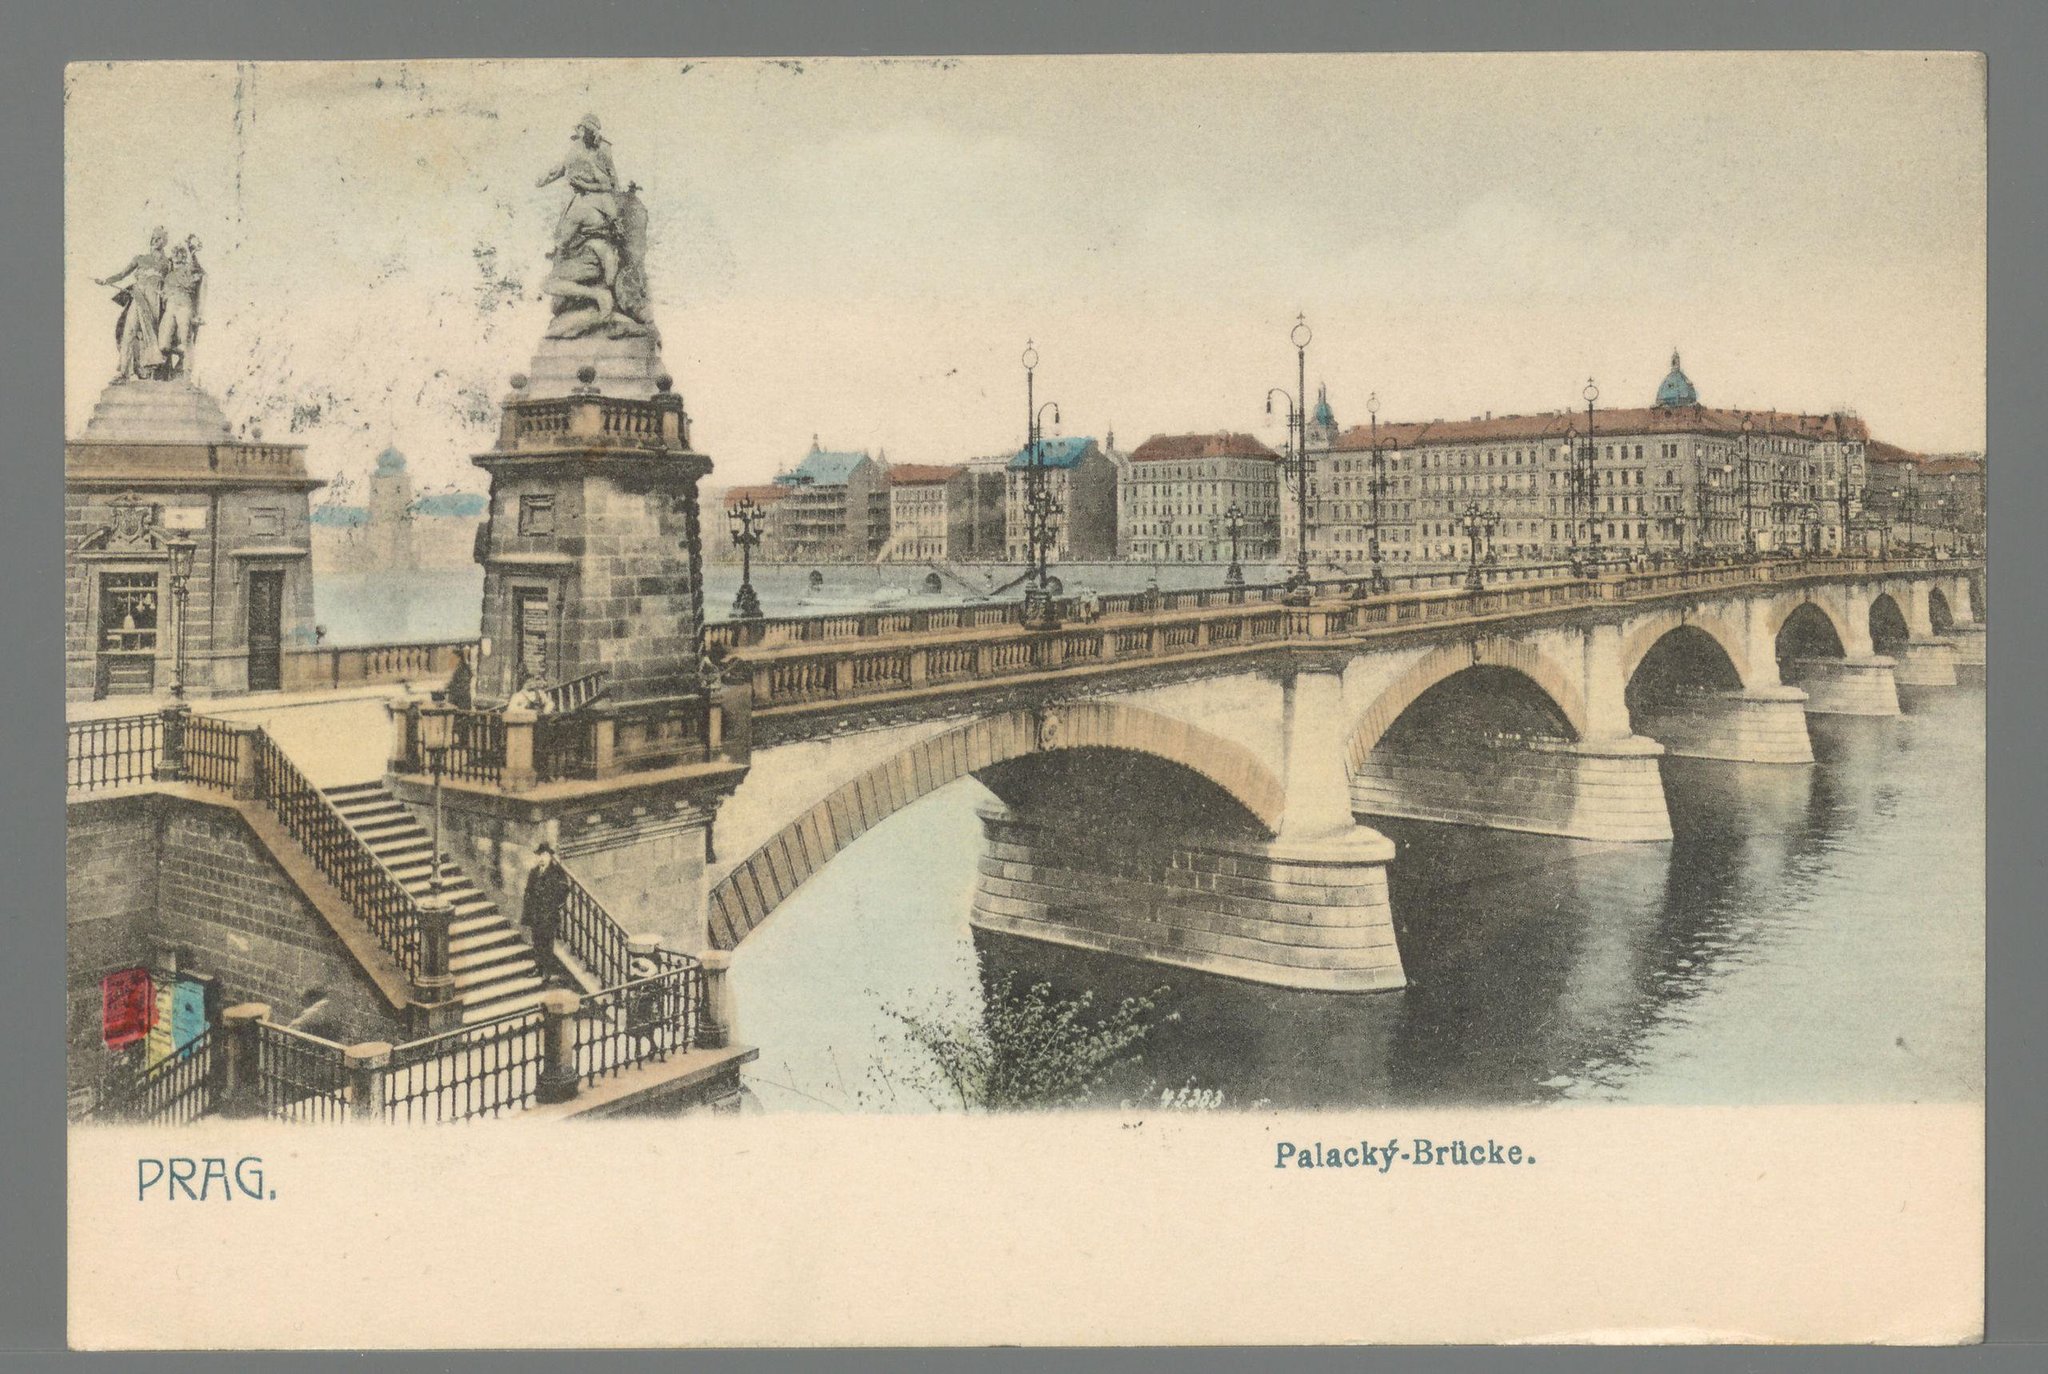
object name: photomechanical print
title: Prag. Palacký-Brücke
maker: Anonymous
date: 1900-1906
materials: cardboard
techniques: photograph, hand coloring, writing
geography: prague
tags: canals, waters (in city), bridge in city across river, canal, etc.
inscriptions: postage stamp